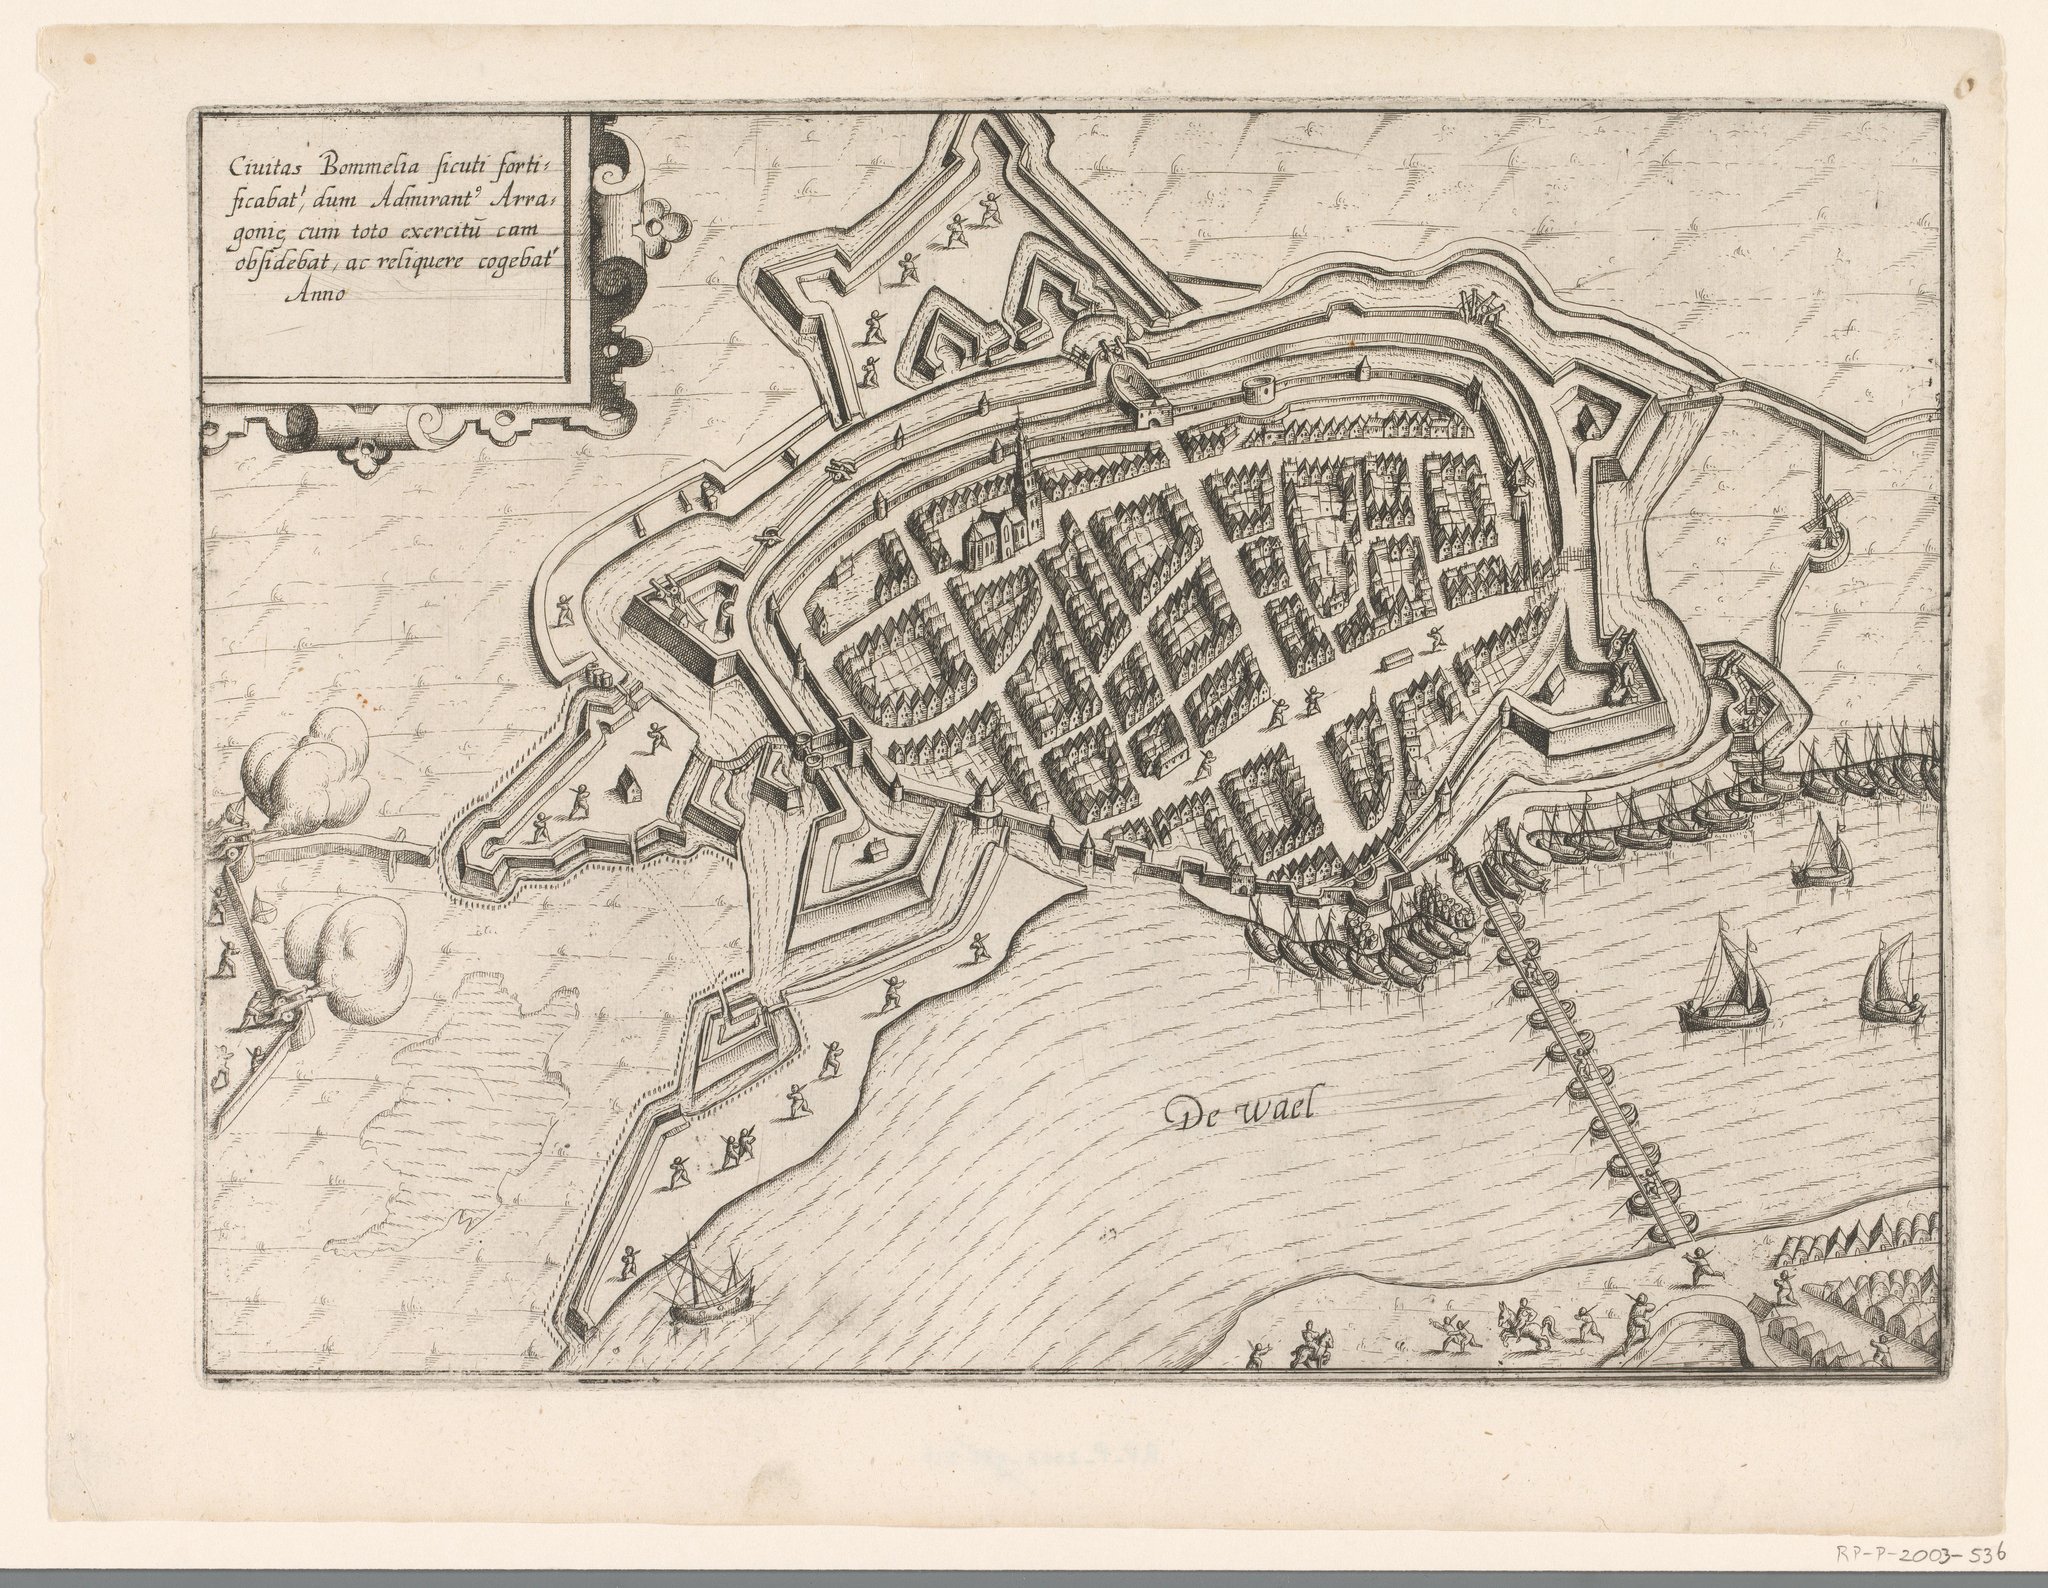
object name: history print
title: Civitas Bommelia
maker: lambert cornelisz.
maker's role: draughtsman, print maker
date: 1607-1609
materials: paper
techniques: etching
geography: northern netherlands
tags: maps of cities, siege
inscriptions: number: ‘62’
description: Plattegrond van de stad Zaltbommel (Bommel), tijdens het beleg door de Spanjaarden in mei-juni 1599. Onderaan de schipbrug over de Waal. Linksboven een cartouche met de Latijnse titel. Onderdeel van de verzameling kaarten genomen uit een latere editie van: Descrittione di tutti i Paesi Bassi van Lodovico Guicciardini.